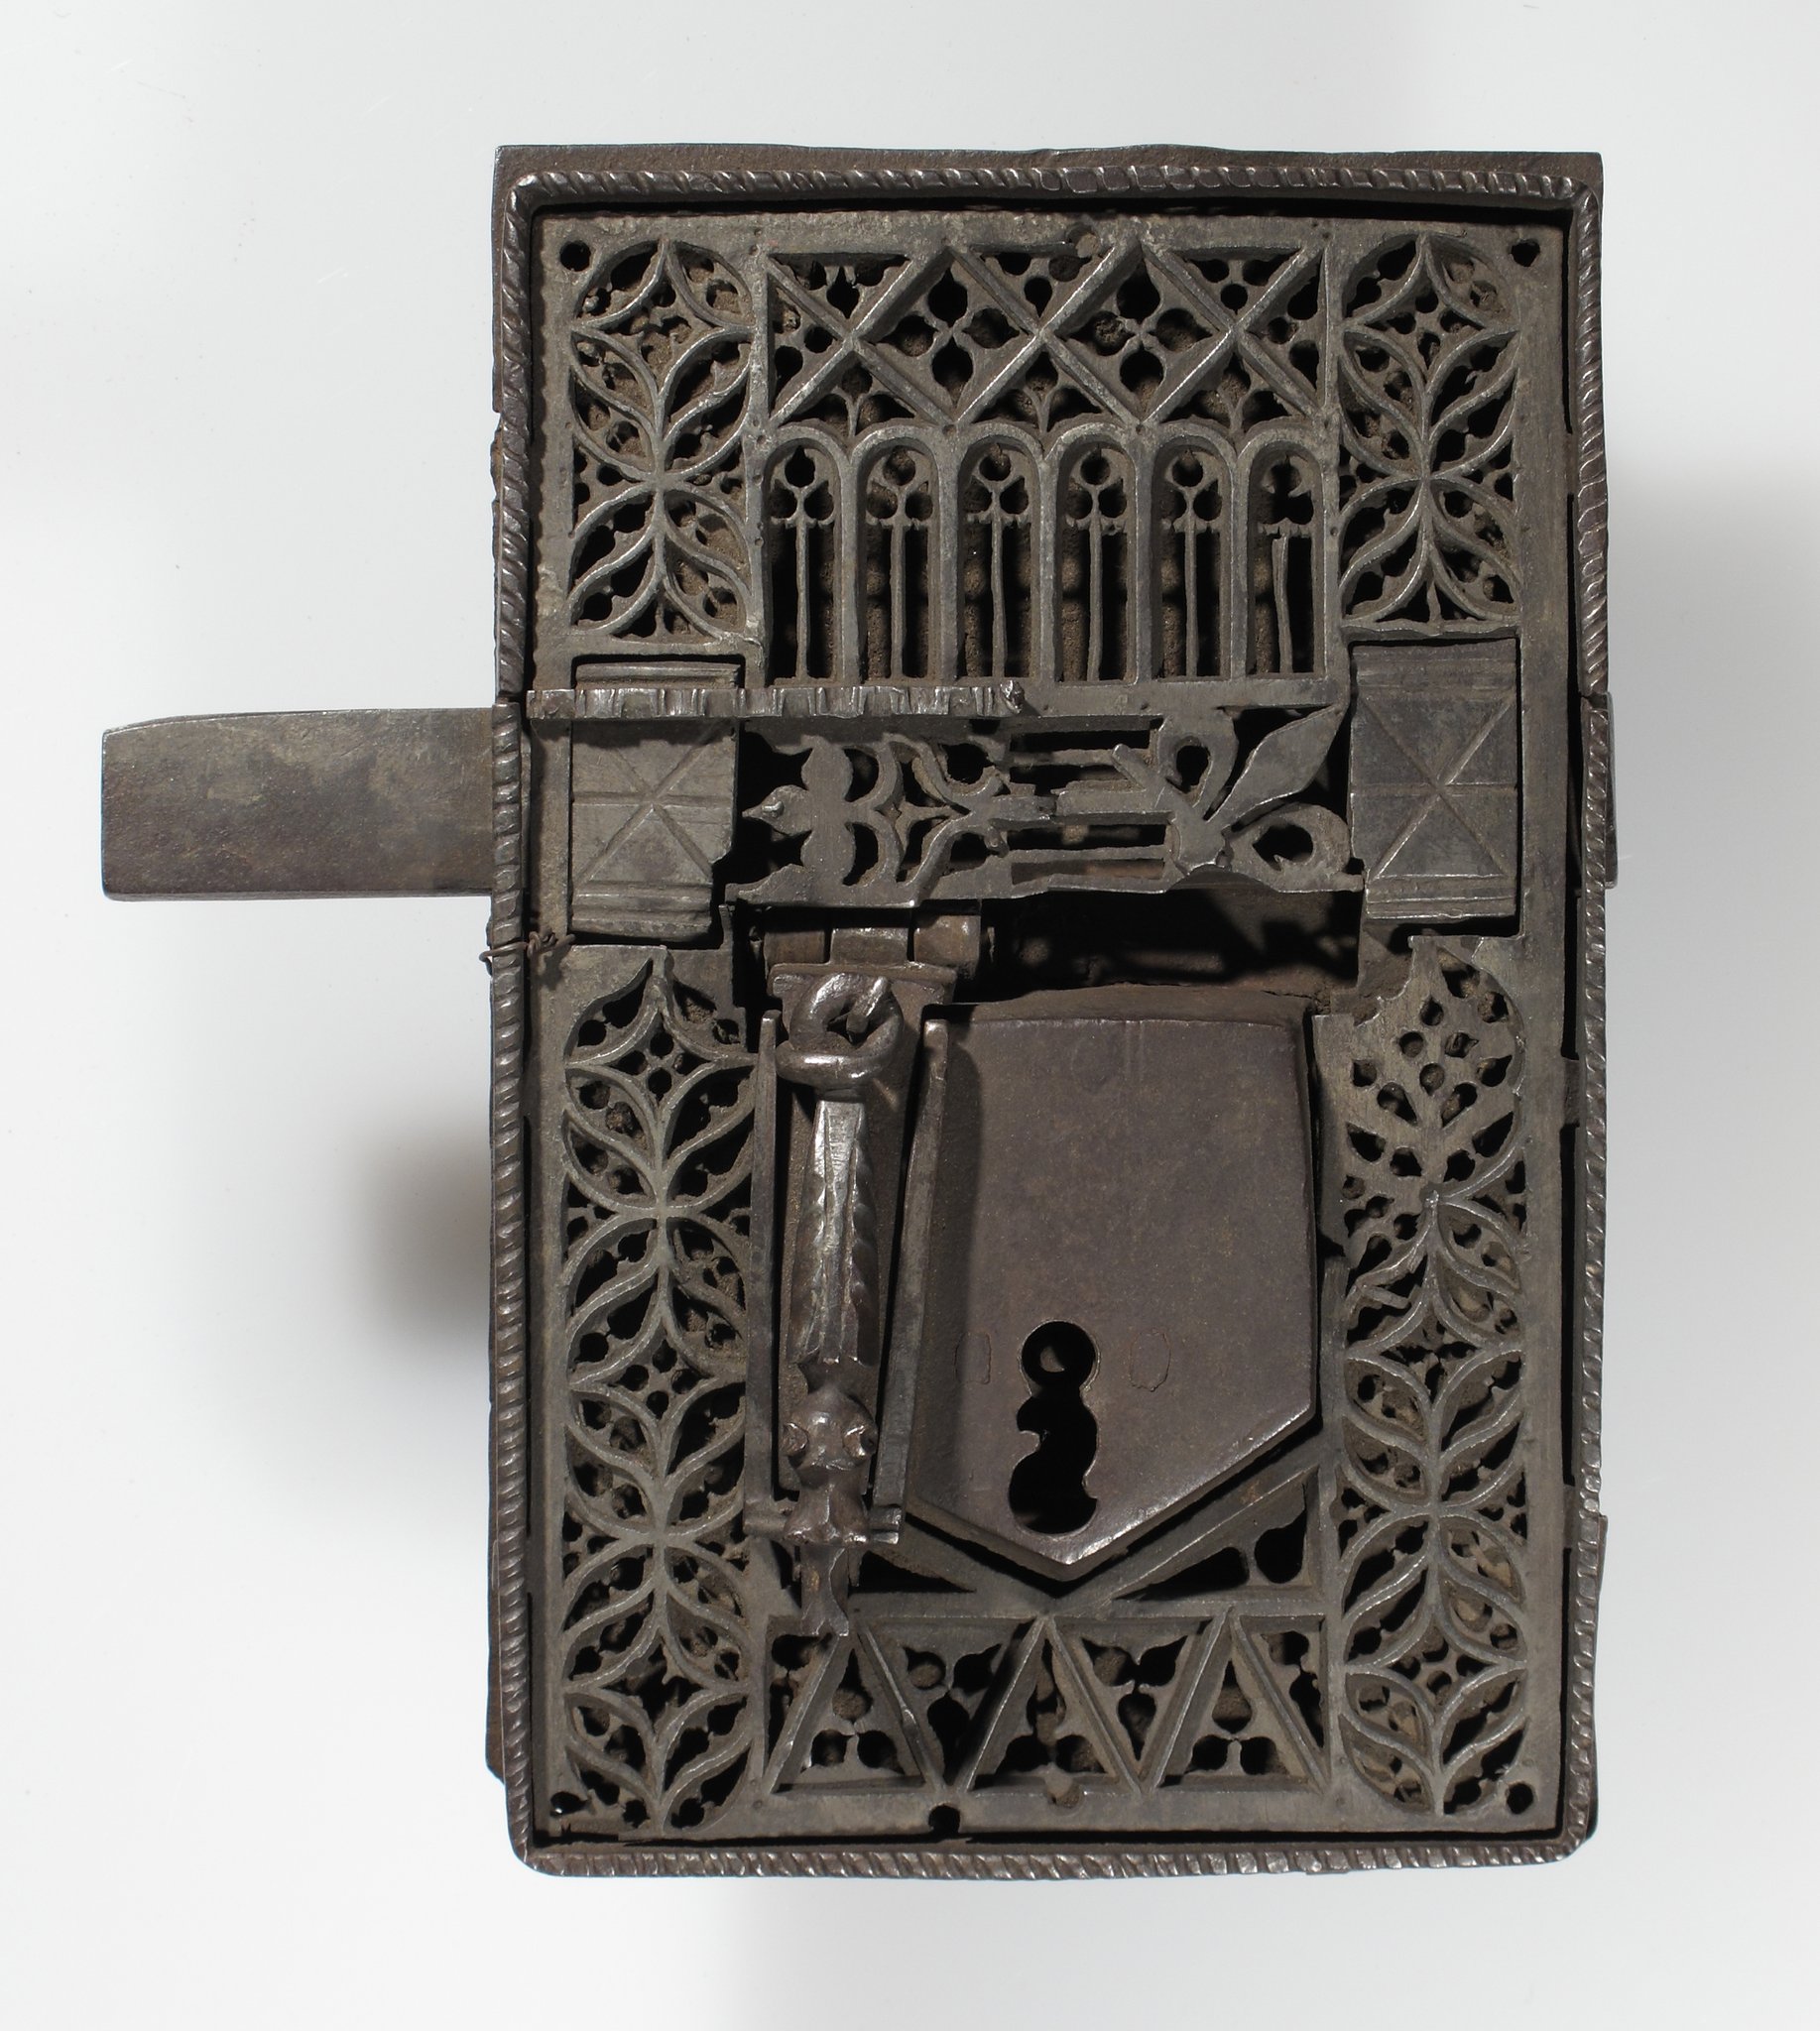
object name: lock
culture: european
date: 1401-1600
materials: iron